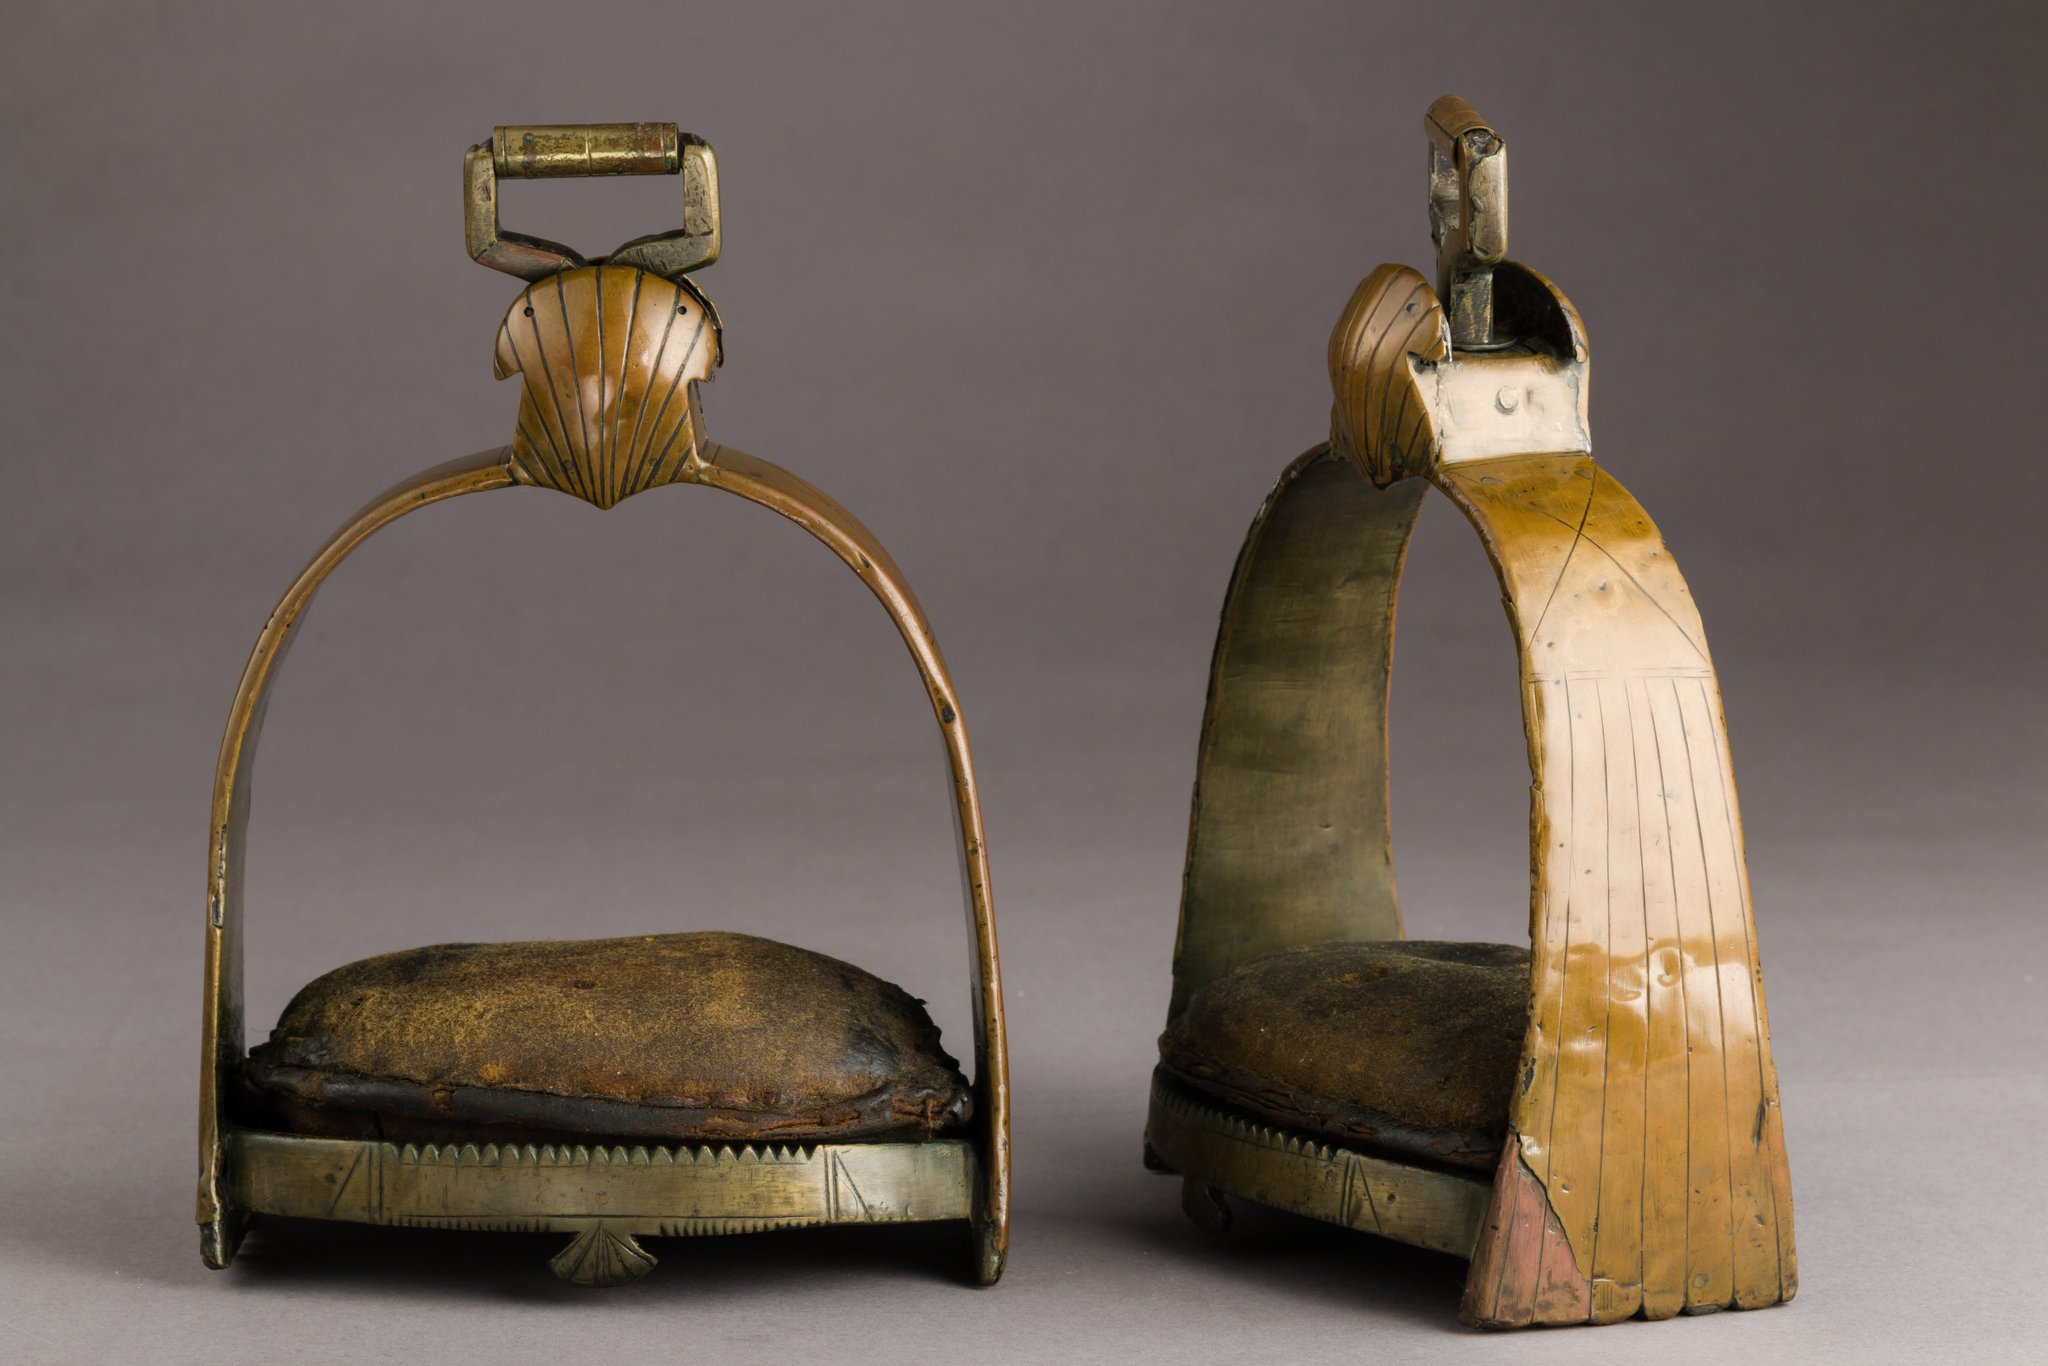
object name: stirrup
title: Pair of Stirrups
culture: german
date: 1601-1700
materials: copper alloy, iron, leather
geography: germany